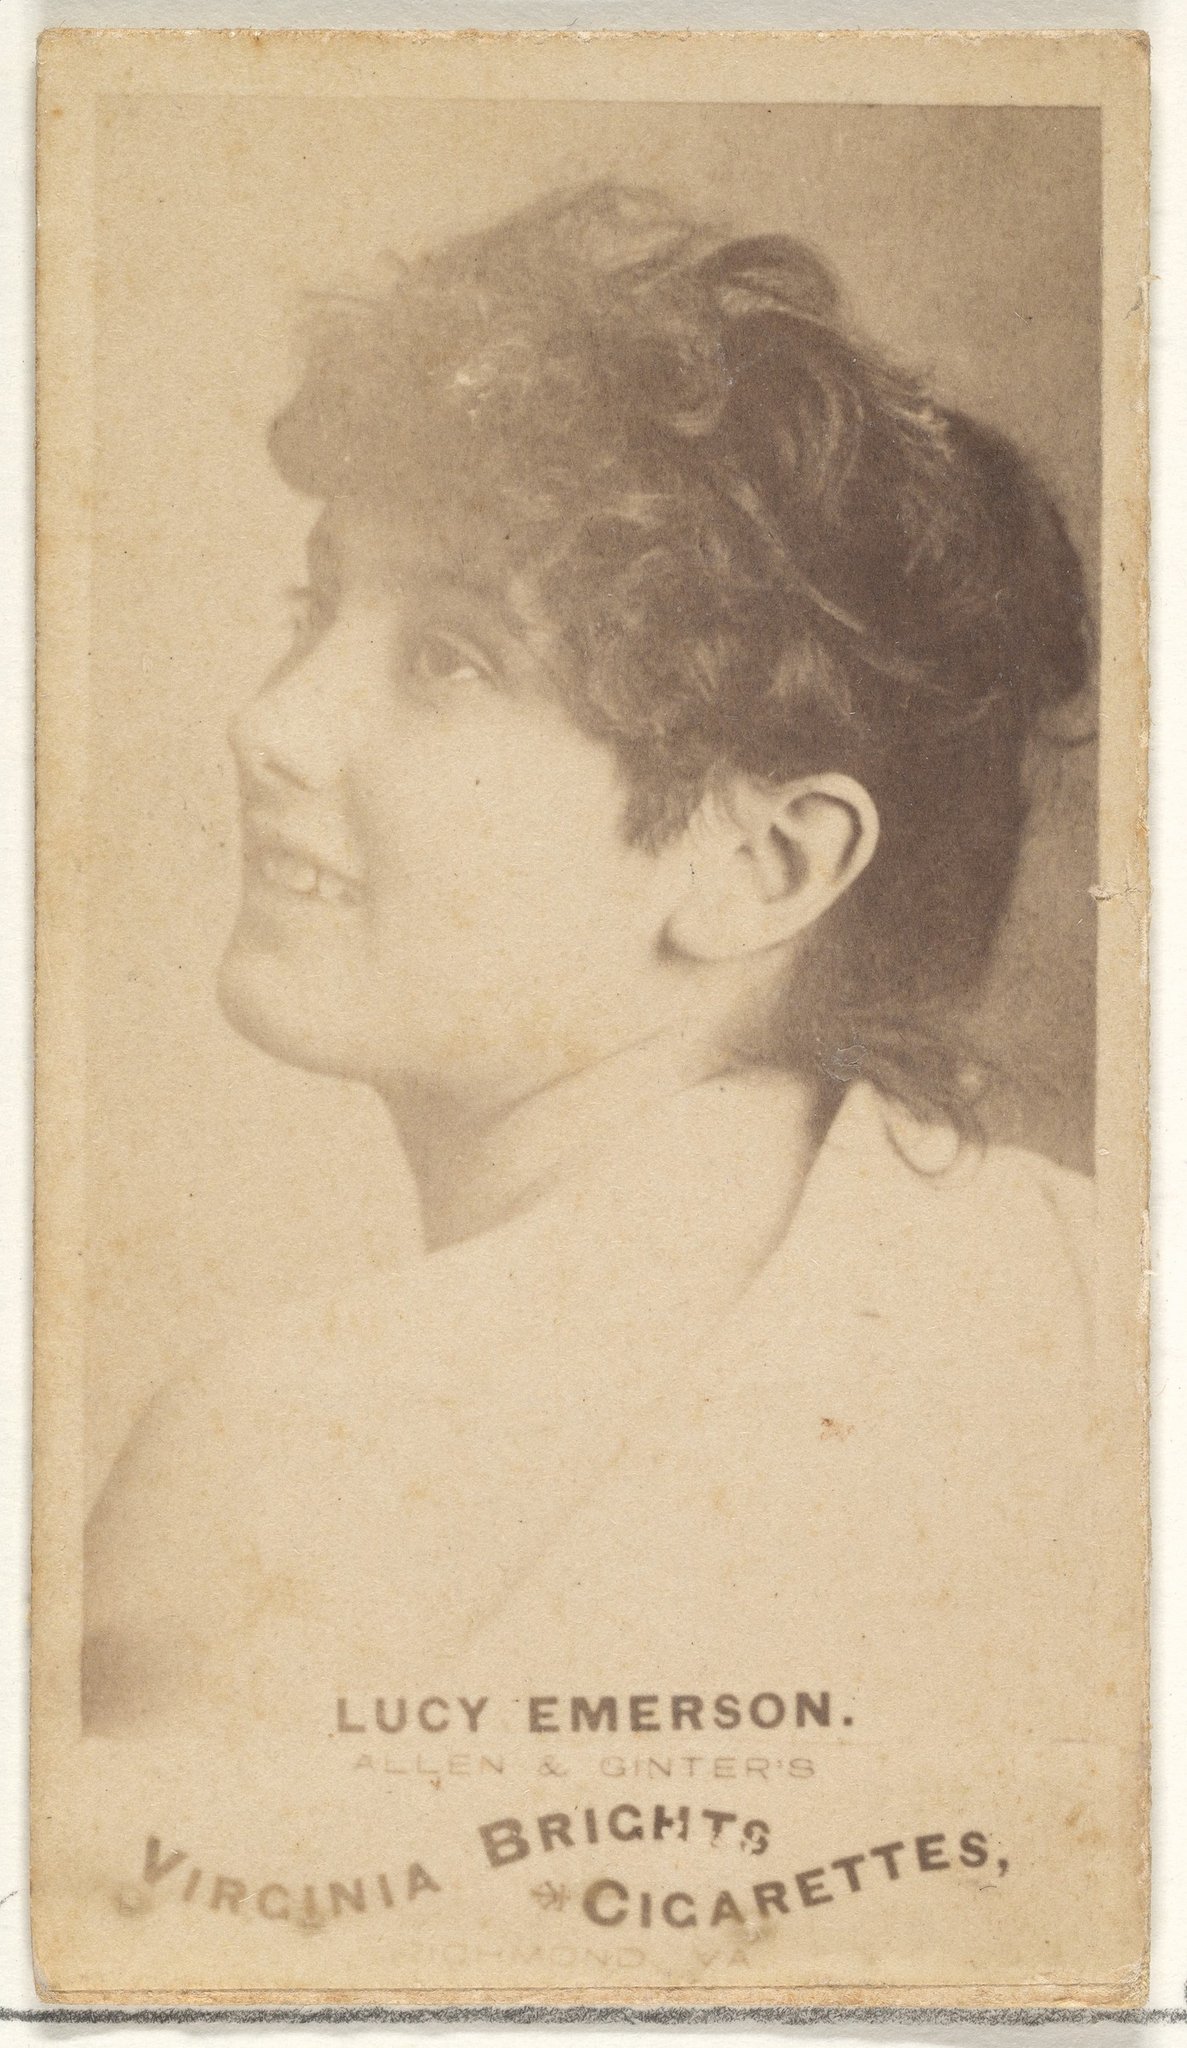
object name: photograph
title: Lucy Emerson, from the Actors and Actresses series (N45, Type 1) for Virginia Brights Cigarettes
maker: allen & ginter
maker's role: publisher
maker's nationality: american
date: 1888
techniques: albumen silver print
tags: portraits,women,actresses